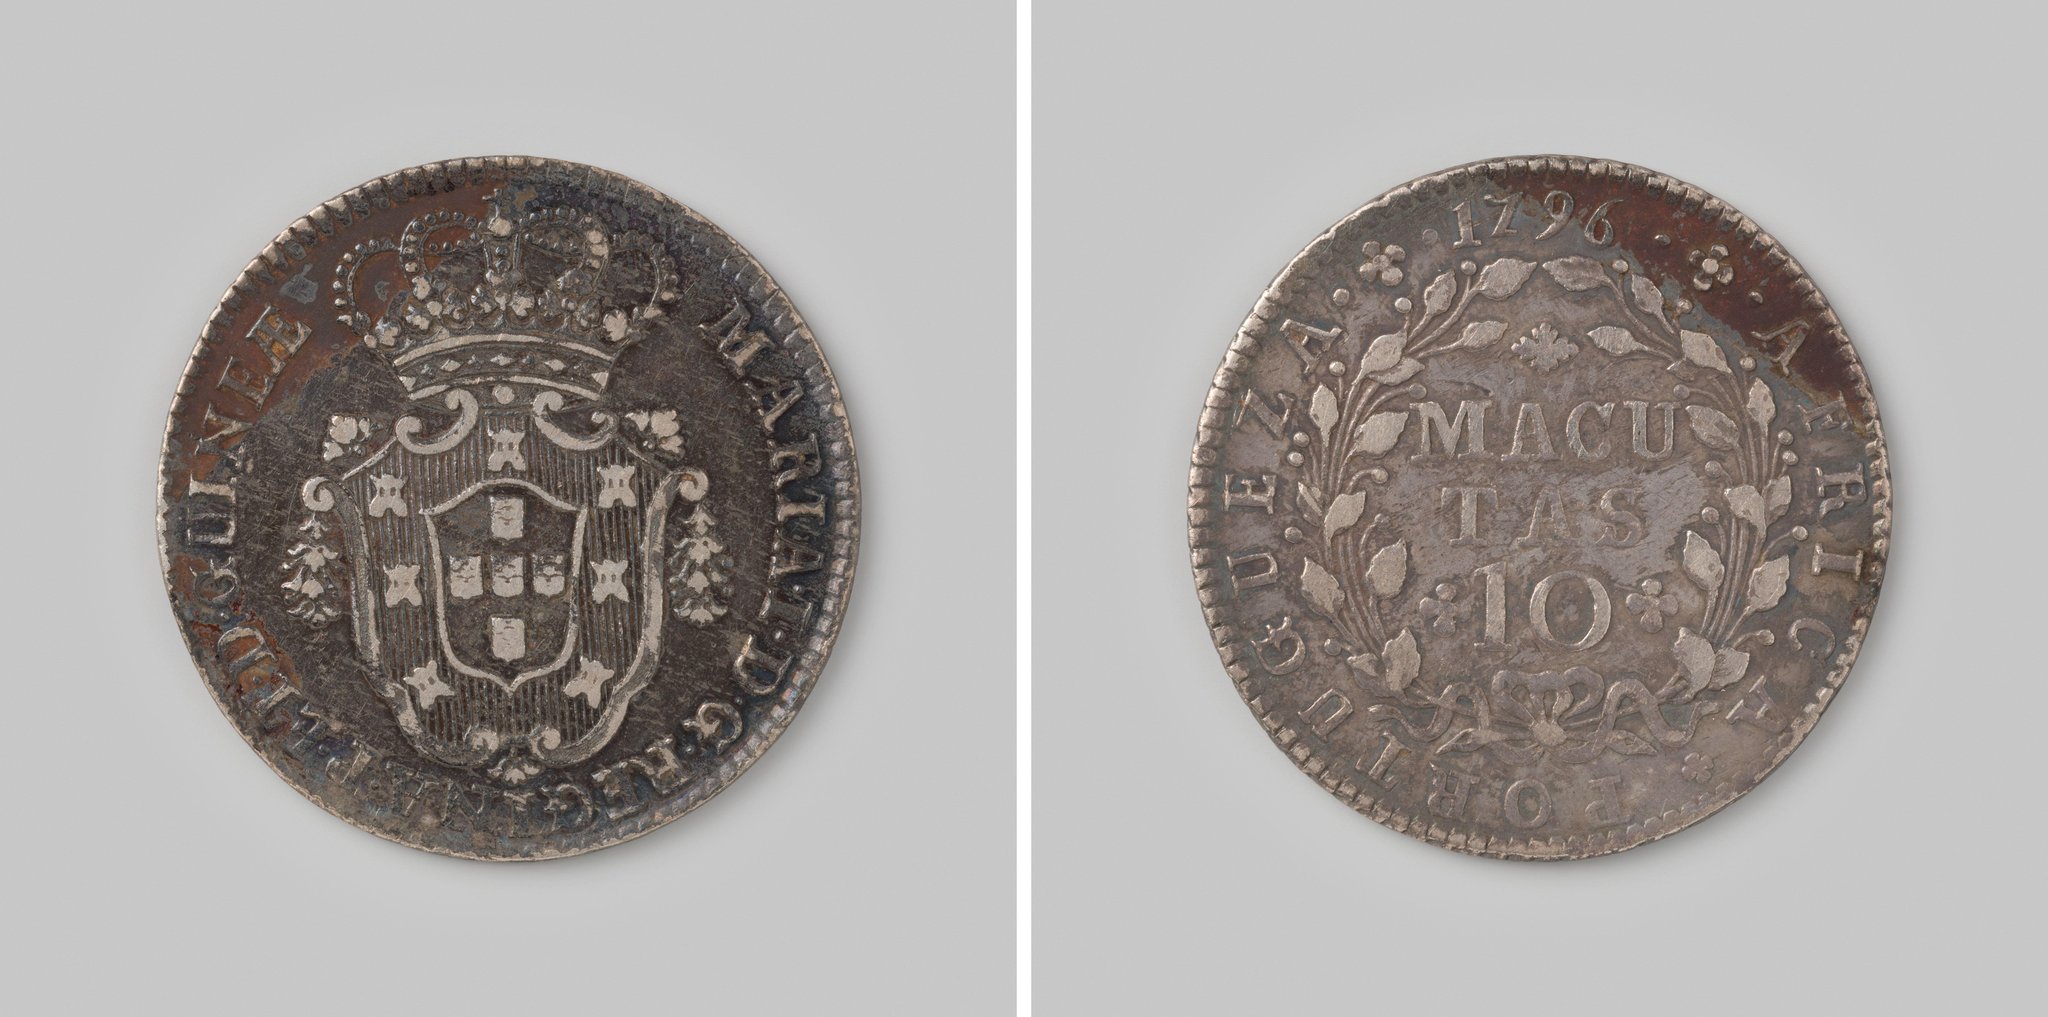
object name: coin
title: Angola, koningin Maria I van Portugal,10 macutas,1796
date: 1796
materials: silver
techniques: striking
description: Zilveren munt. Voorzijde: barok wapenschild van Portugal, waarboven kroon. Keerzijde: tussen twee samengebonden takken in twee regels waarde-aanduiding: macutas 10. Omschrift: Africa Portugueza met jaartal bovenaan. Bloemrand.